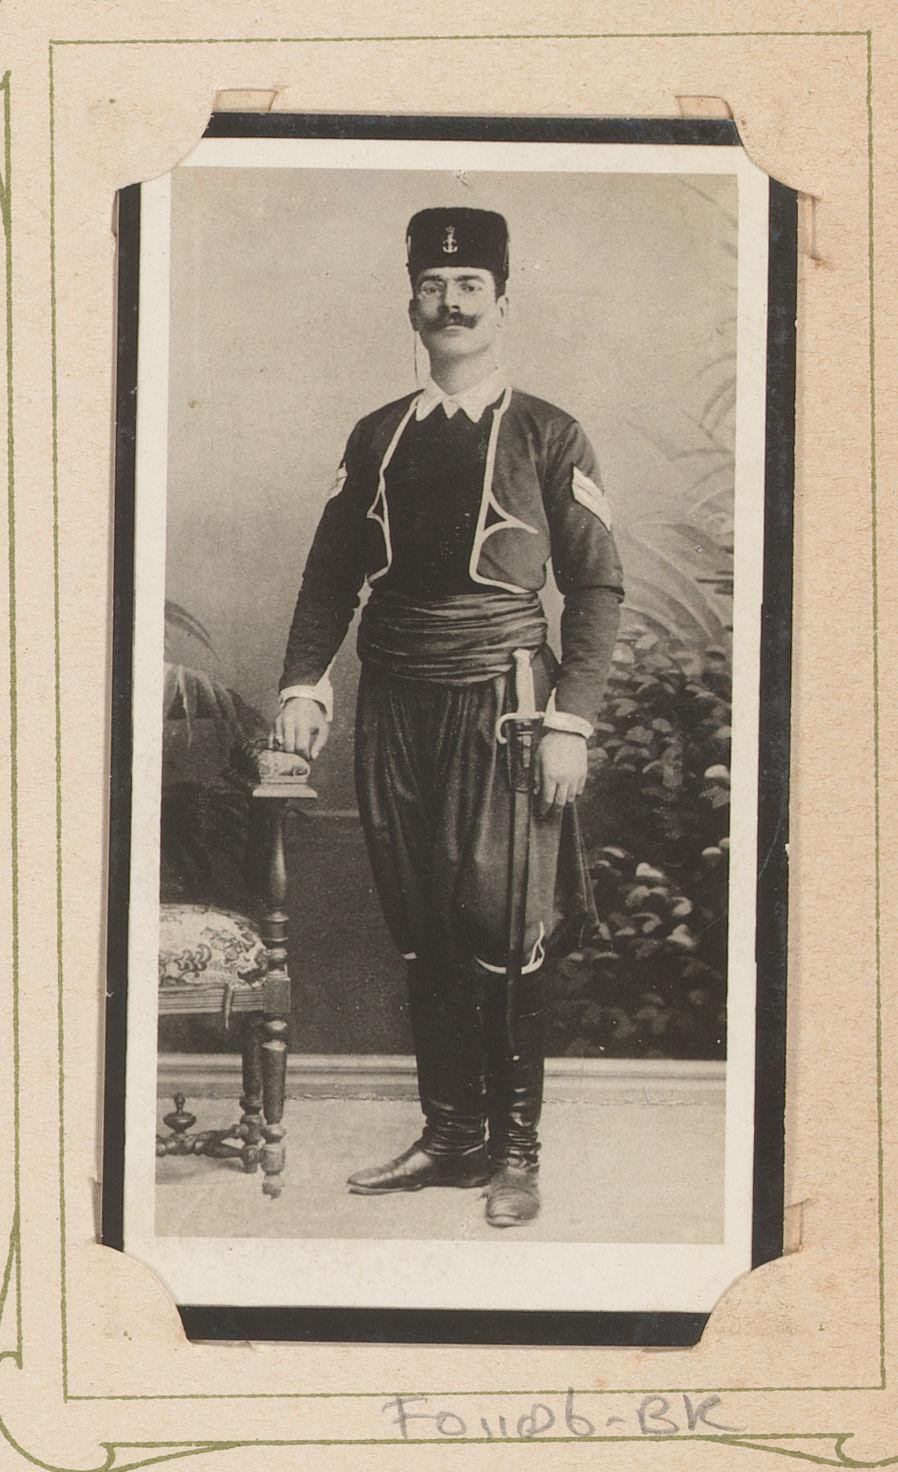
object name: photograph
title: Portret van een Griekse politieagent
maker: Anonymous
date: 1904-1905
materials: photographic support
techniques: gelatin silver print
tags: historical persons, policeman, constable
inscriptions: inscription: ‘No. 3./ Gendarme van Creta.’